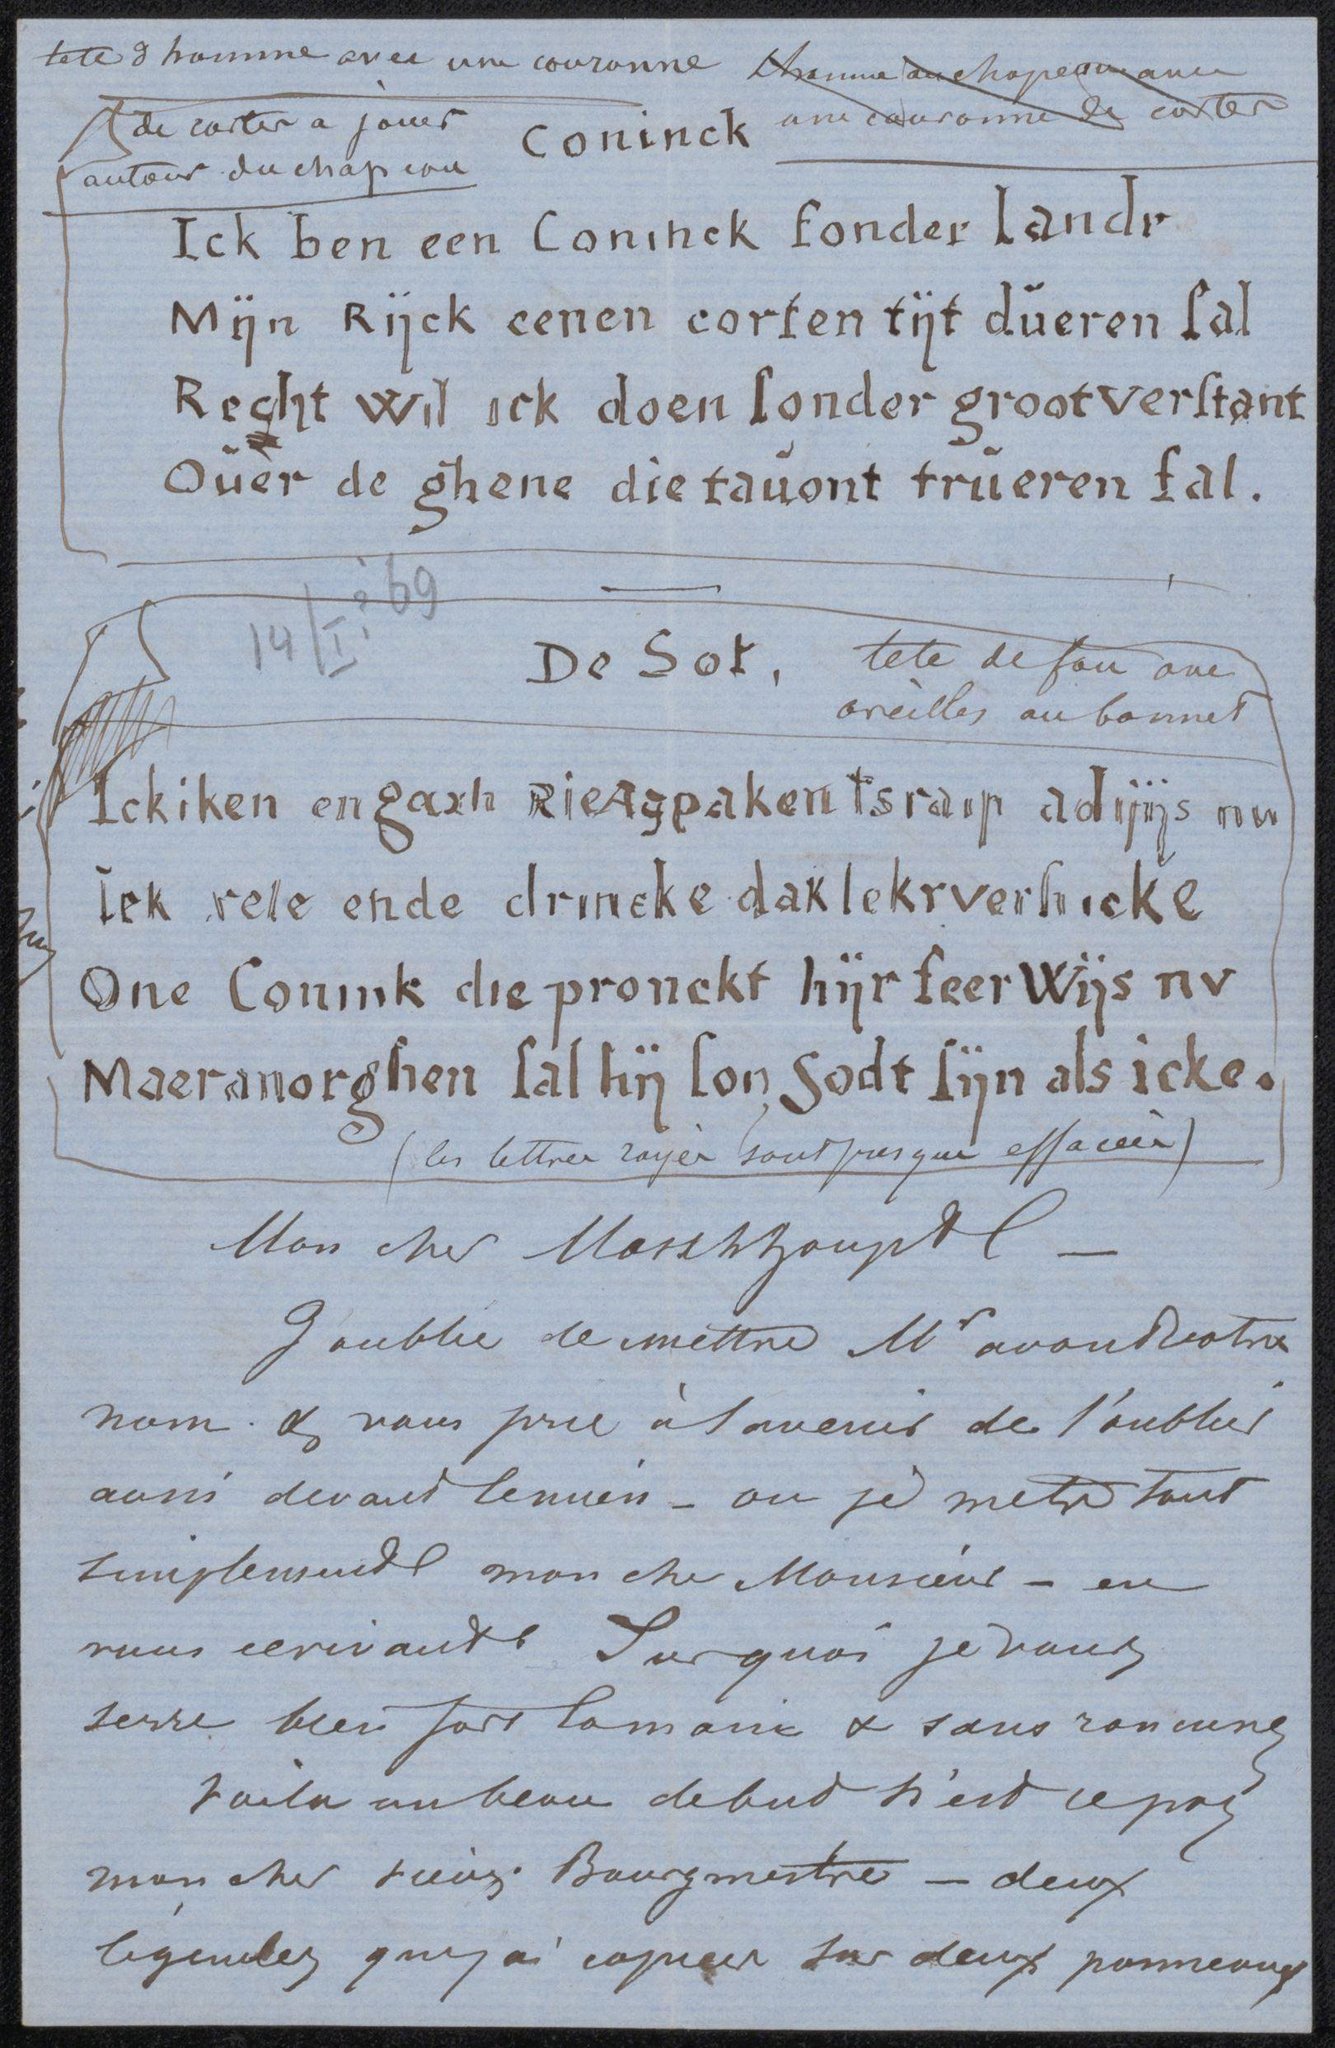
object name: letter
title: Brief aan Jan Hendrik Maschaupt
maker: adolphe mouilleron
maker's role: draughtsman, print maker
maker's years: 1820-1881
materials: ink, paper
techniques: pen, writing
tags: jan hendrik maschaupt, leiden, amsterdam, painter, print maker, draughtsman, rembrandt van rijn, painting (including book-illumination, miniature-painting), diseases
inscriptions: collector's mark: ‘RPK’